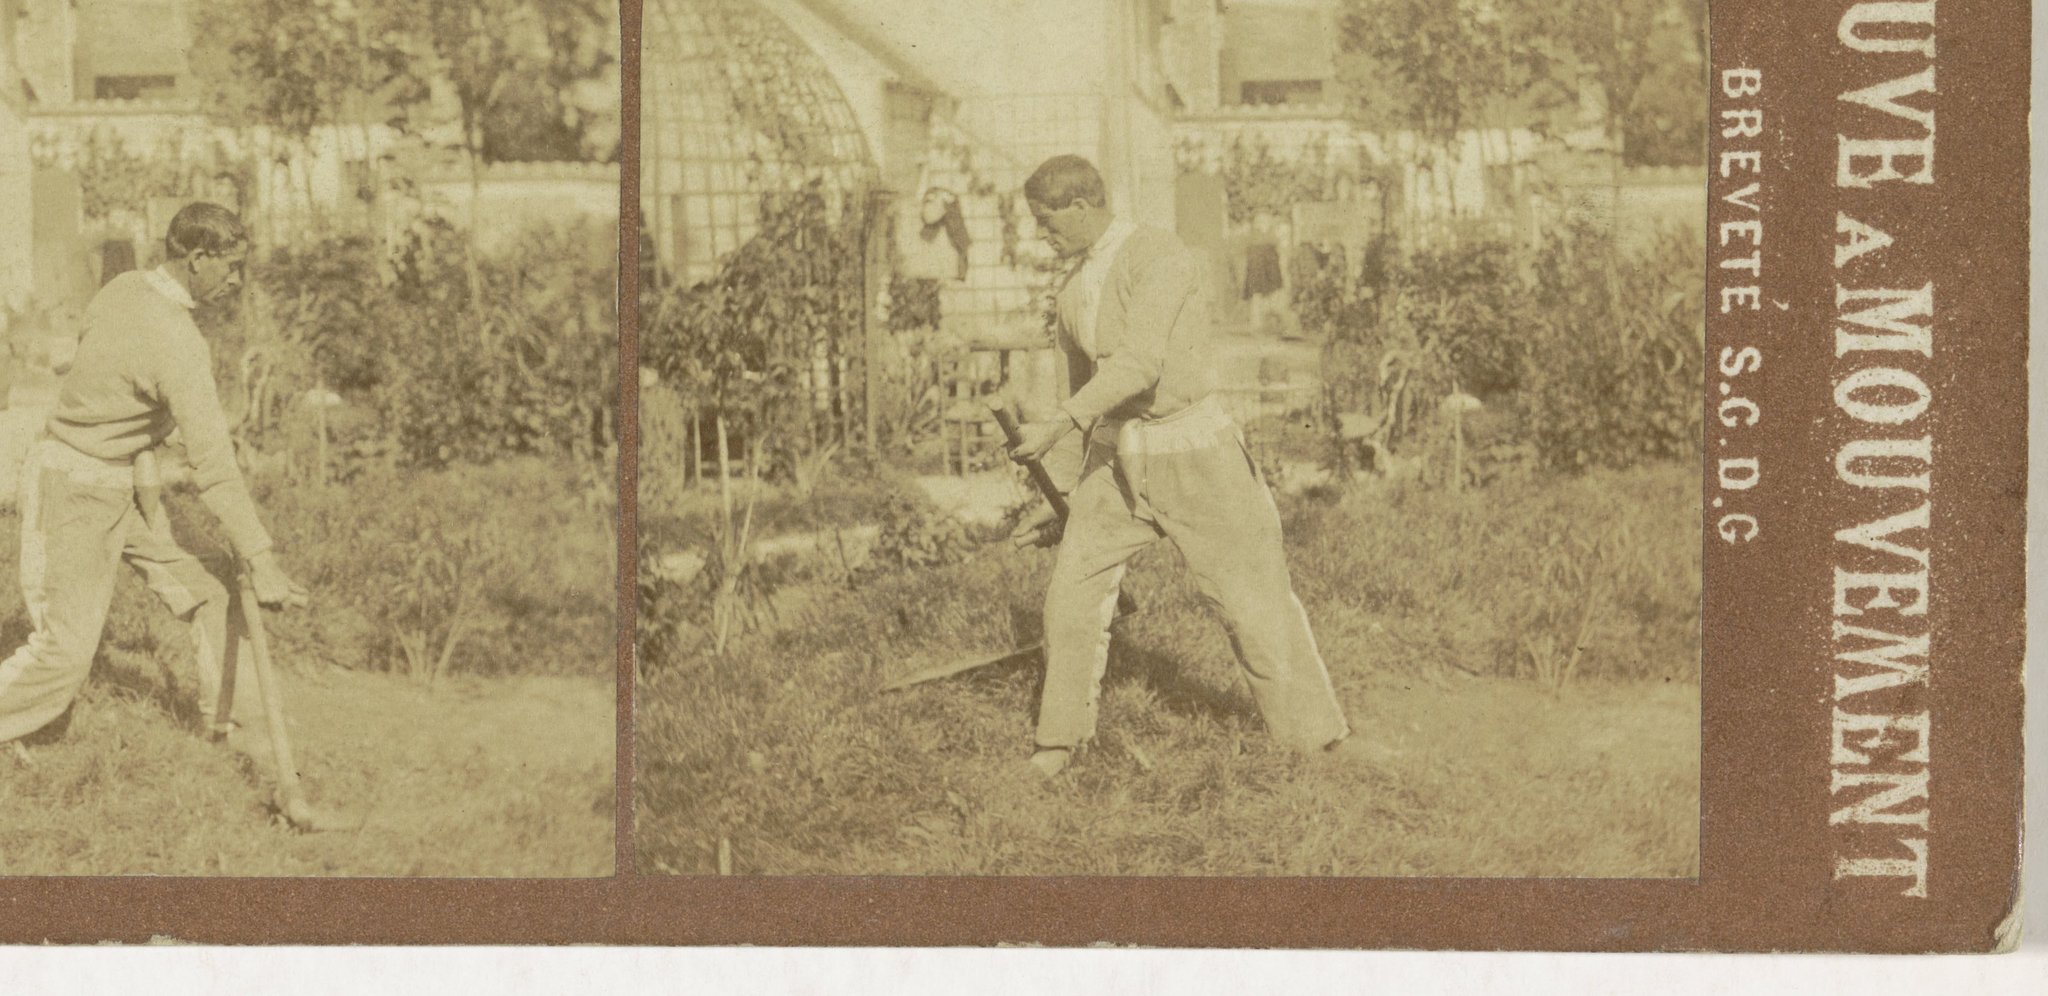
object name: stereograph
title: ÉPREUVE A MOUVEMENT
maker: Anonymous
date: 1855-1875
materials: cardboard, paper, photographic support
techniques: albumen print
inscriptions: inscription: ‘11’, check stamp: ‘Brevete F. T. S.G.D.C (?)’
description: Quasi-stereofoto van een man die gras aan het maaien is.